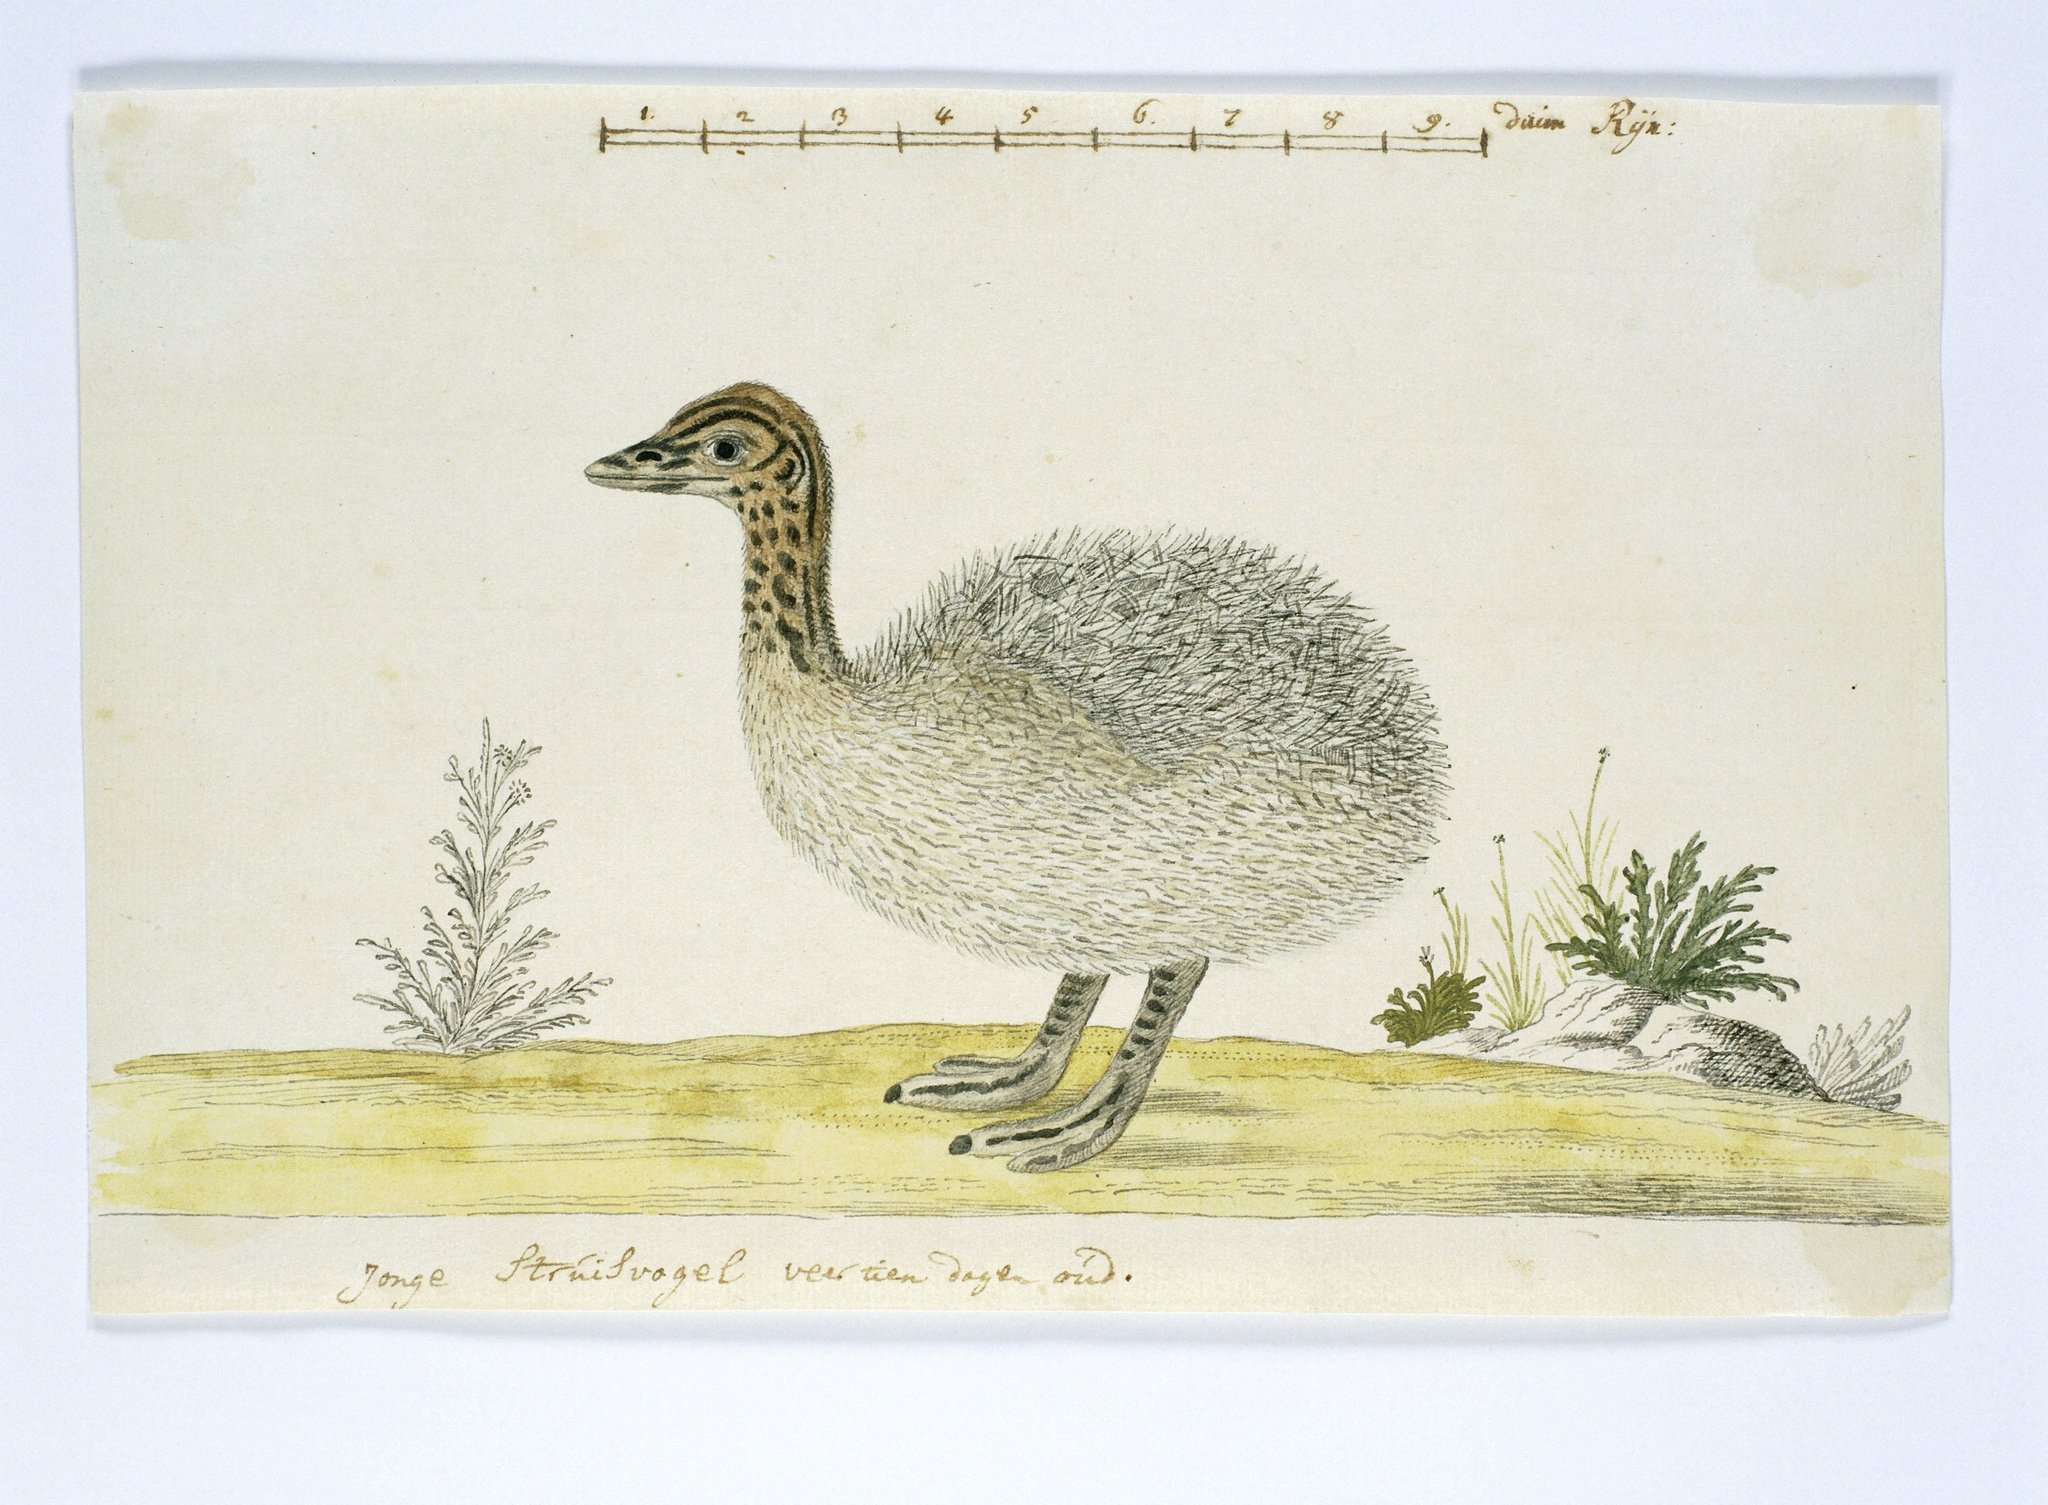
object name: drawing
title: Struthio camelus (Common ostrich)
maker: robert jacob gordon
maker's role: draughtsman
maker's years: 1743-1795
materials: chalk, ink, paper, pencil, watercolor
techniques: brush, pen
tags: walker and runner birds: ostrich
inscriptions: annotation: ‘Jonge Struisvogel veertien dagen oud. ; schaal met: duijm Rijn:’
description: Vogelstudie: jonge struisvogel (Struthio camelus), 14 dagen oud; met schaalverdeling in Rijnlandse duim. Eieren worden door het mannetje uitgebroed, na 6-8 weken komt het jong tevoorschijn.